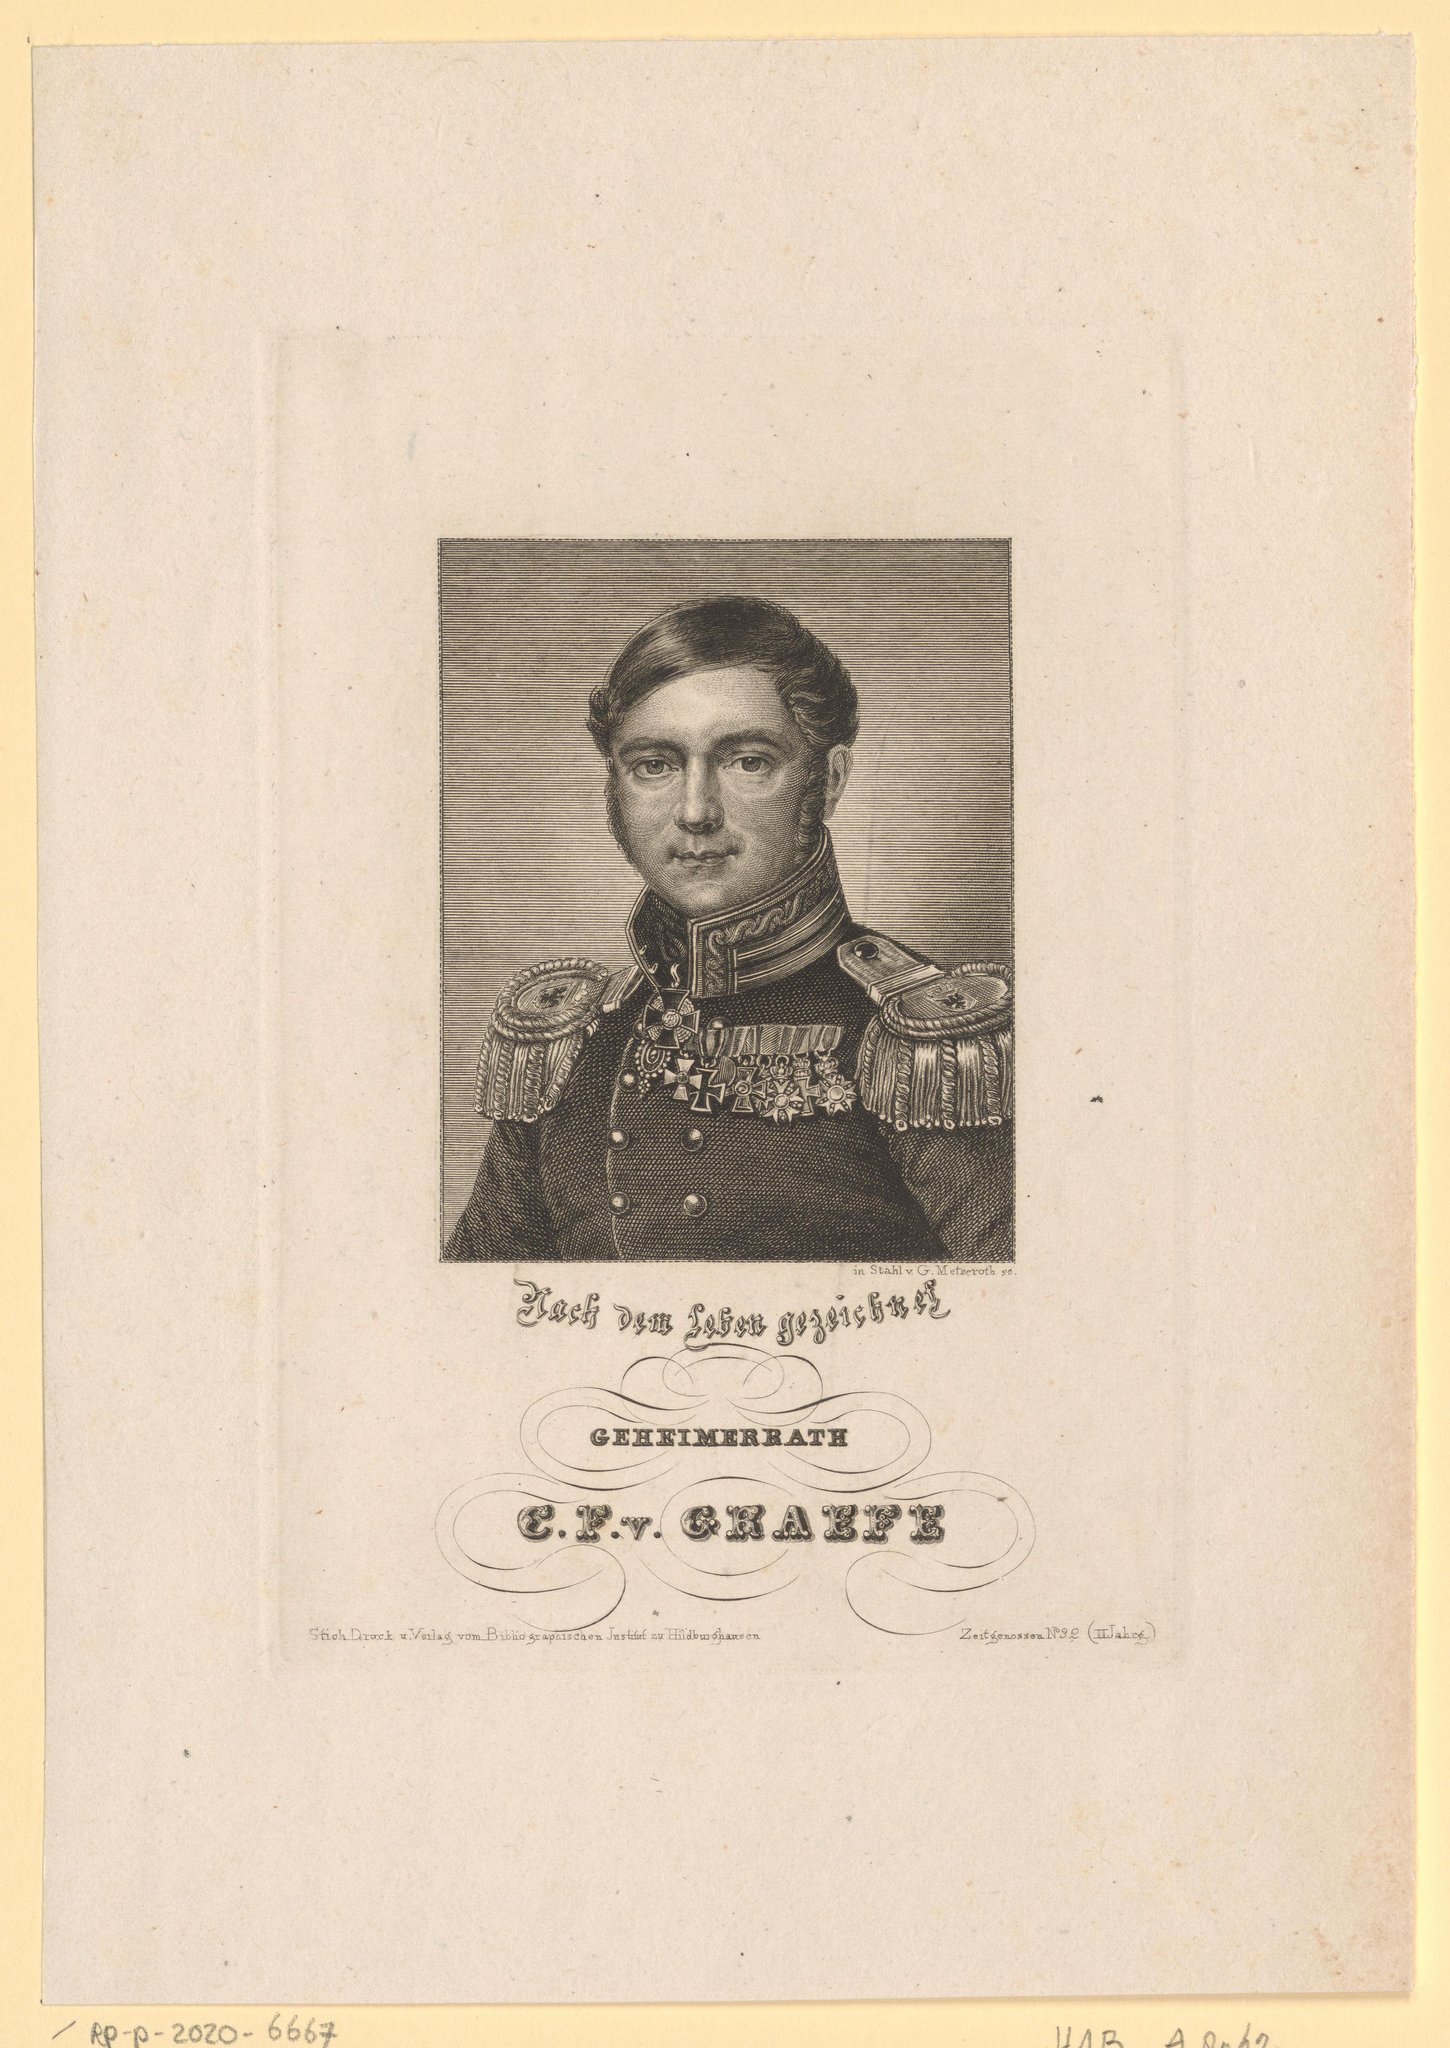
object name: print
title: Zeitgenossen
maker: g. metzeroth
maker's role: print maker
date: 1829-1840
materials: paper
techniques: engraving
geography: hildburghausen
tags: karl ferdinand von gräfe, historical persons, physician, doctor (+ portrait of scholar, scientist), professor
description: Prent hoort bij de portretserie 'Zeitgenossen', uitgegeven tussen 1829 en circa 1840.